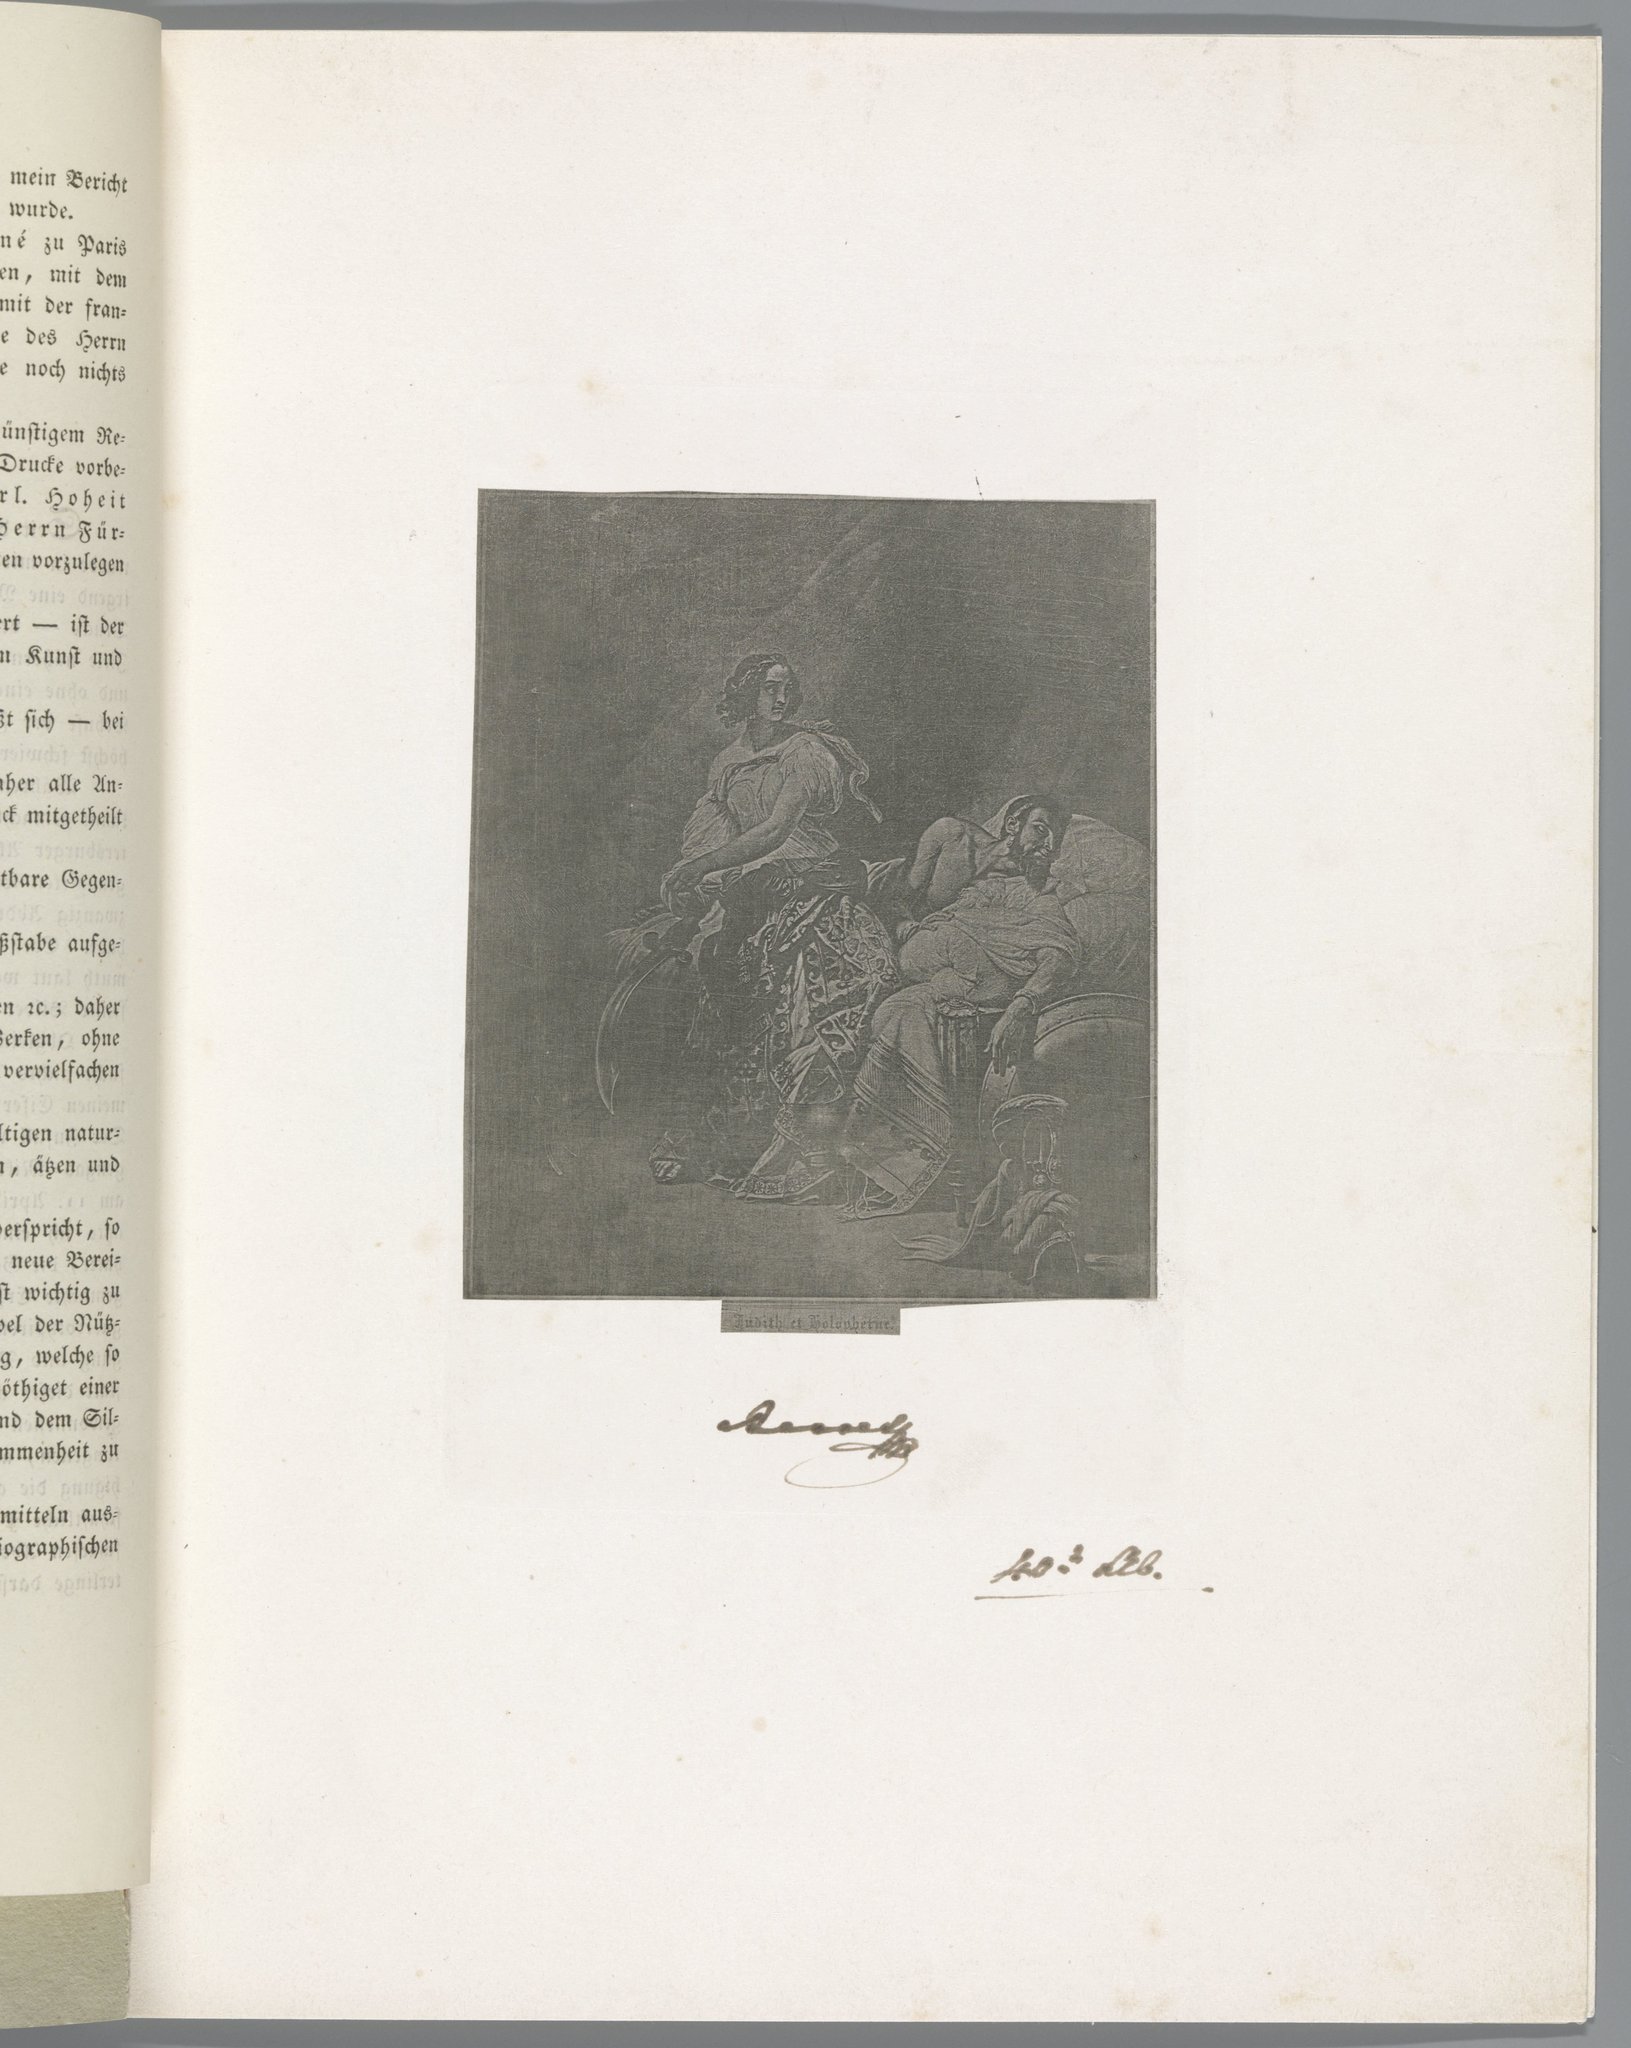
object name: print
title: Judith et Holopherne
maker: christian joseph berres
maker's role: anatoom, chirurg, fotograaf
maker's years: 1796-1844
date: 1840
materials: paper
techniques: etching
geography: paris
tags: holofernes drinks too much, and falls asleep on the bed, judith and holofernes (judith 8-16)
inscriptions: inscription: ‘40 -2 Lib.’, name: ‘Berres’